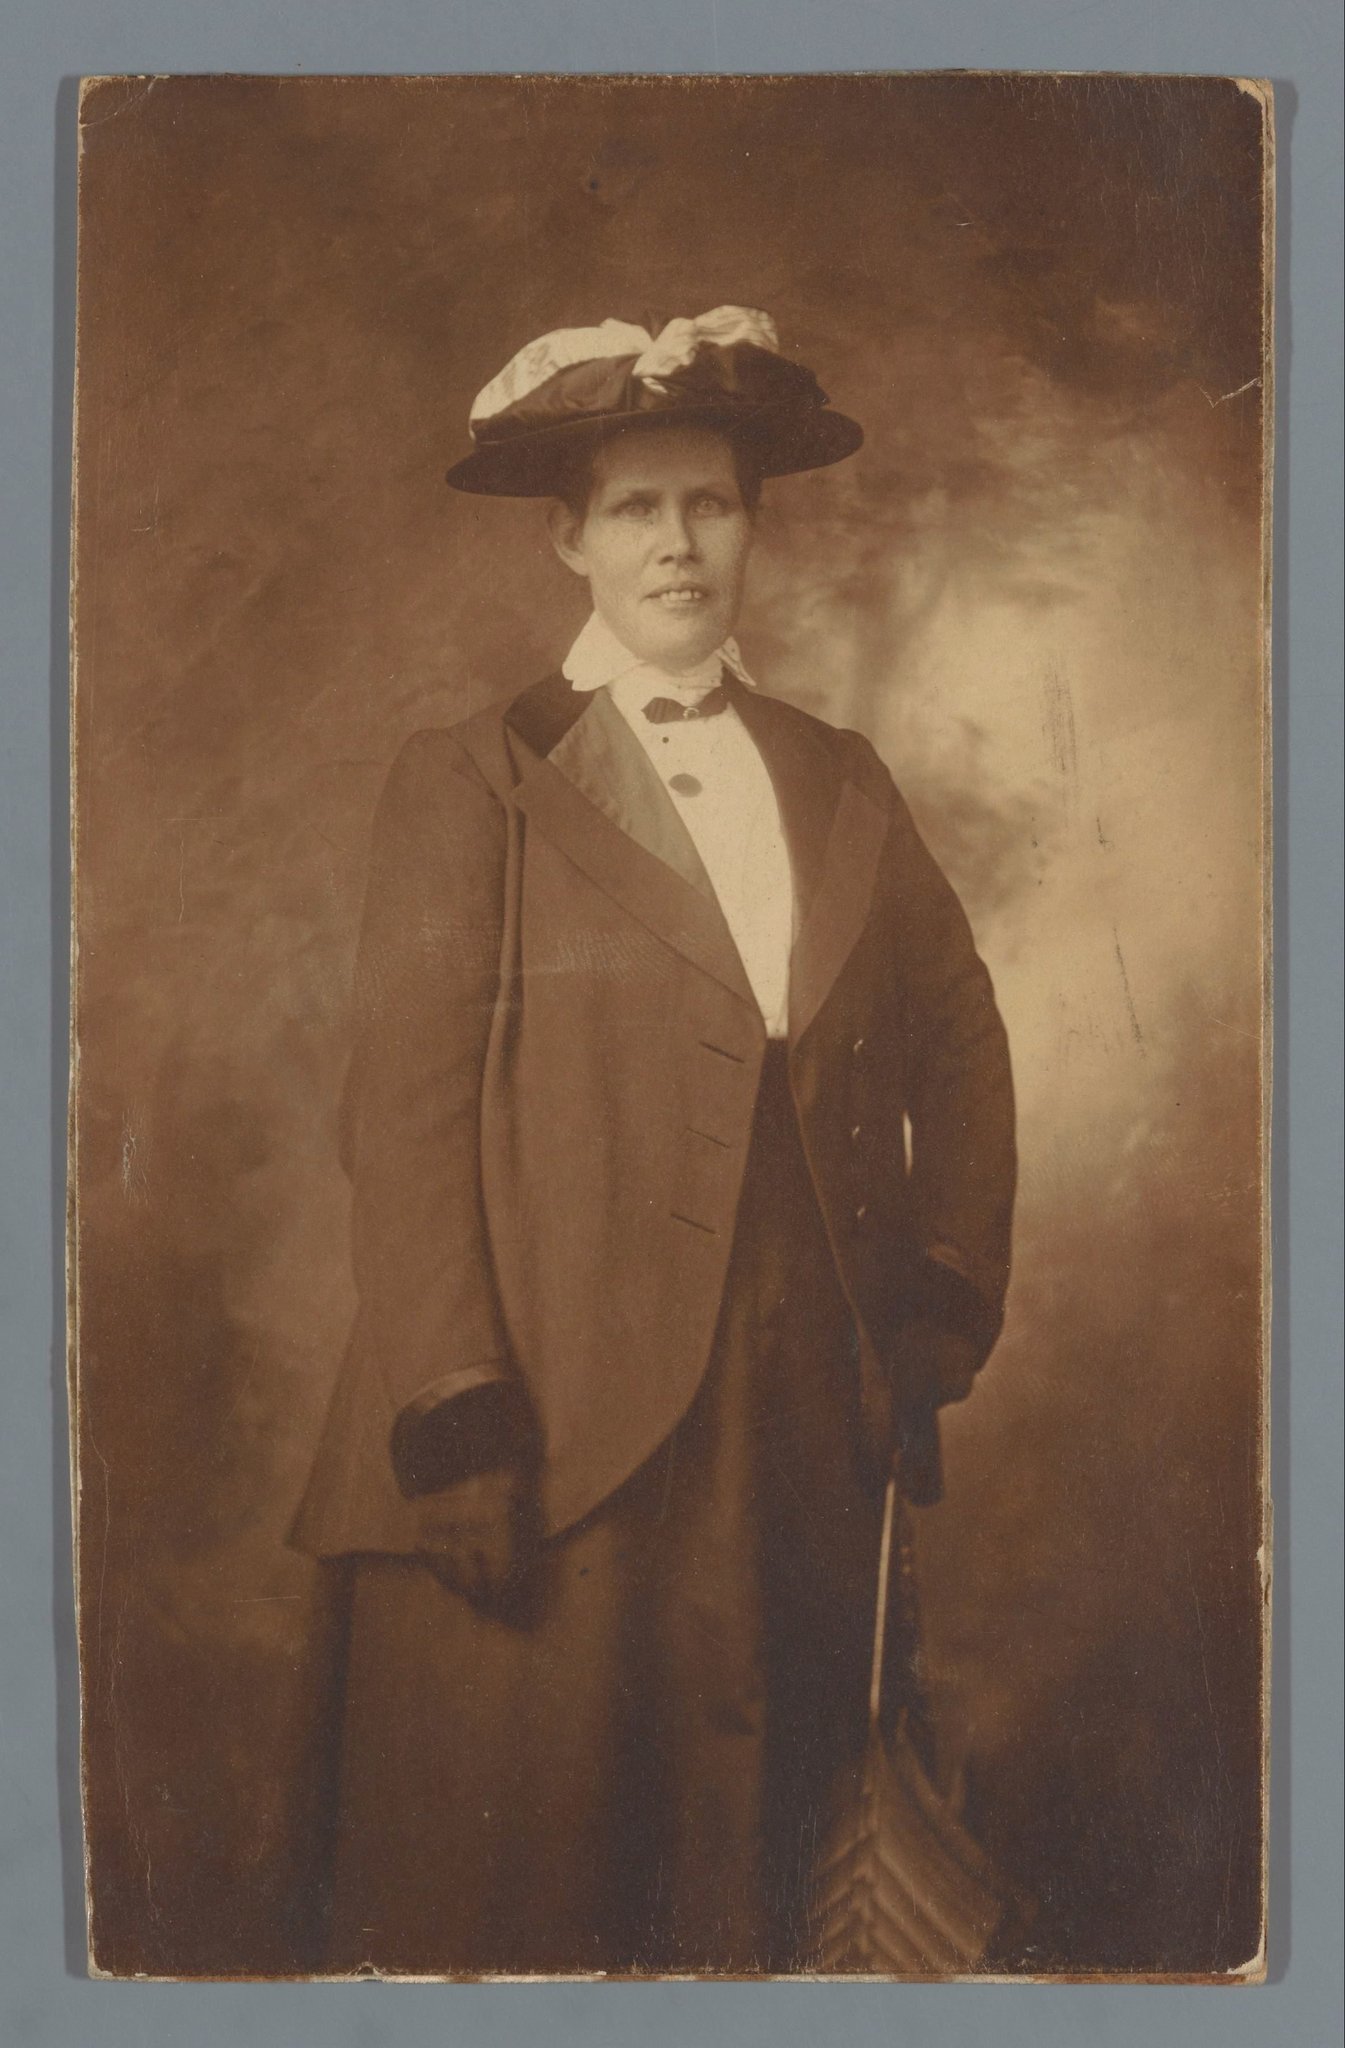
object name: photograph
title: Portret van een onbekende vrouw met een hoed en een paraplu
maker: Anonymous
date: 1900-1915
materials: photographic support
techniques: gelatin silver print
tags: adult woman, head-gear: hat, umbrella